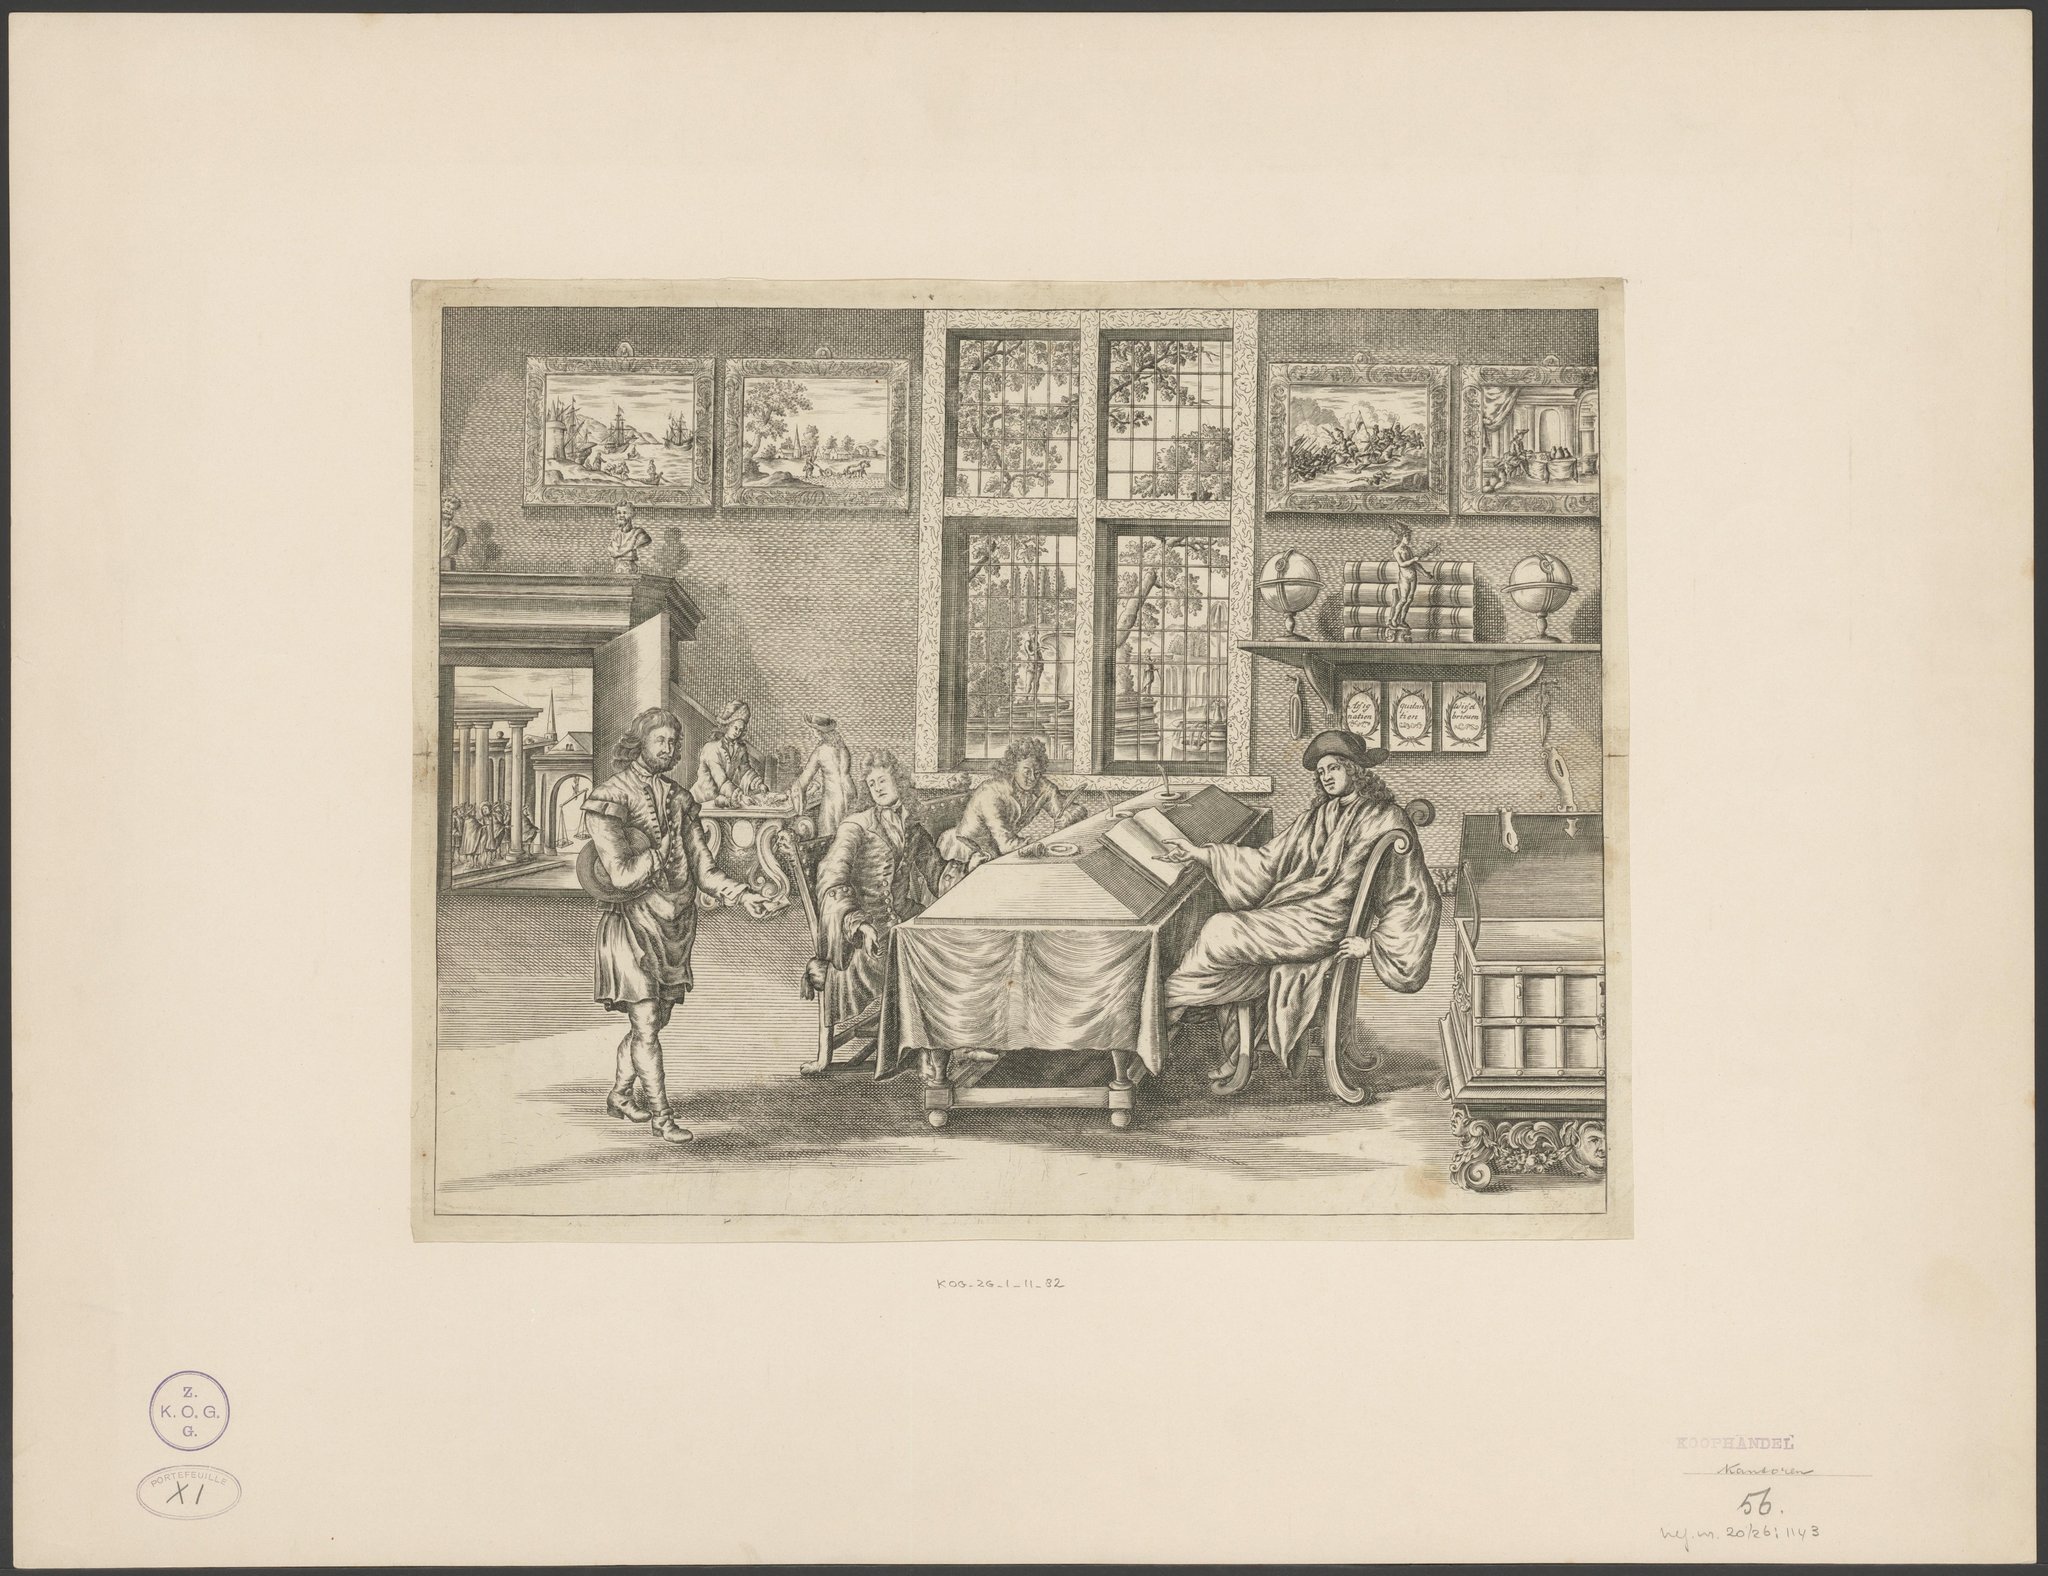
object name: print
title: Mannen in een wisselbank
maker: Anonymous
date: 1615-1699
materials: paper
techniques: engraving, etching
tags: writing tools, picture, painting, weigh-house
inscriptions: stamp, stamp, collector's mark: Lugt 1641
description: Drie mannen aan een schrijftafel. Een man loopt binnen met een brief in zijn hand. Links achterin wisselen twee mannen geld. Door de open deur van het kantoor is een waag te zien. Rechts aan de muur hangen drie plakkaten met de woorden: Assignatien, quitantien en wisselbrieven. Onderwerpsrubrieken binnen de Atlas Zeden en Gewoonten: Handel, nijverheid en verkeer, Koophandel, Veilingen, Makelaardij en Verzekeringswezen. Kamers te huur.